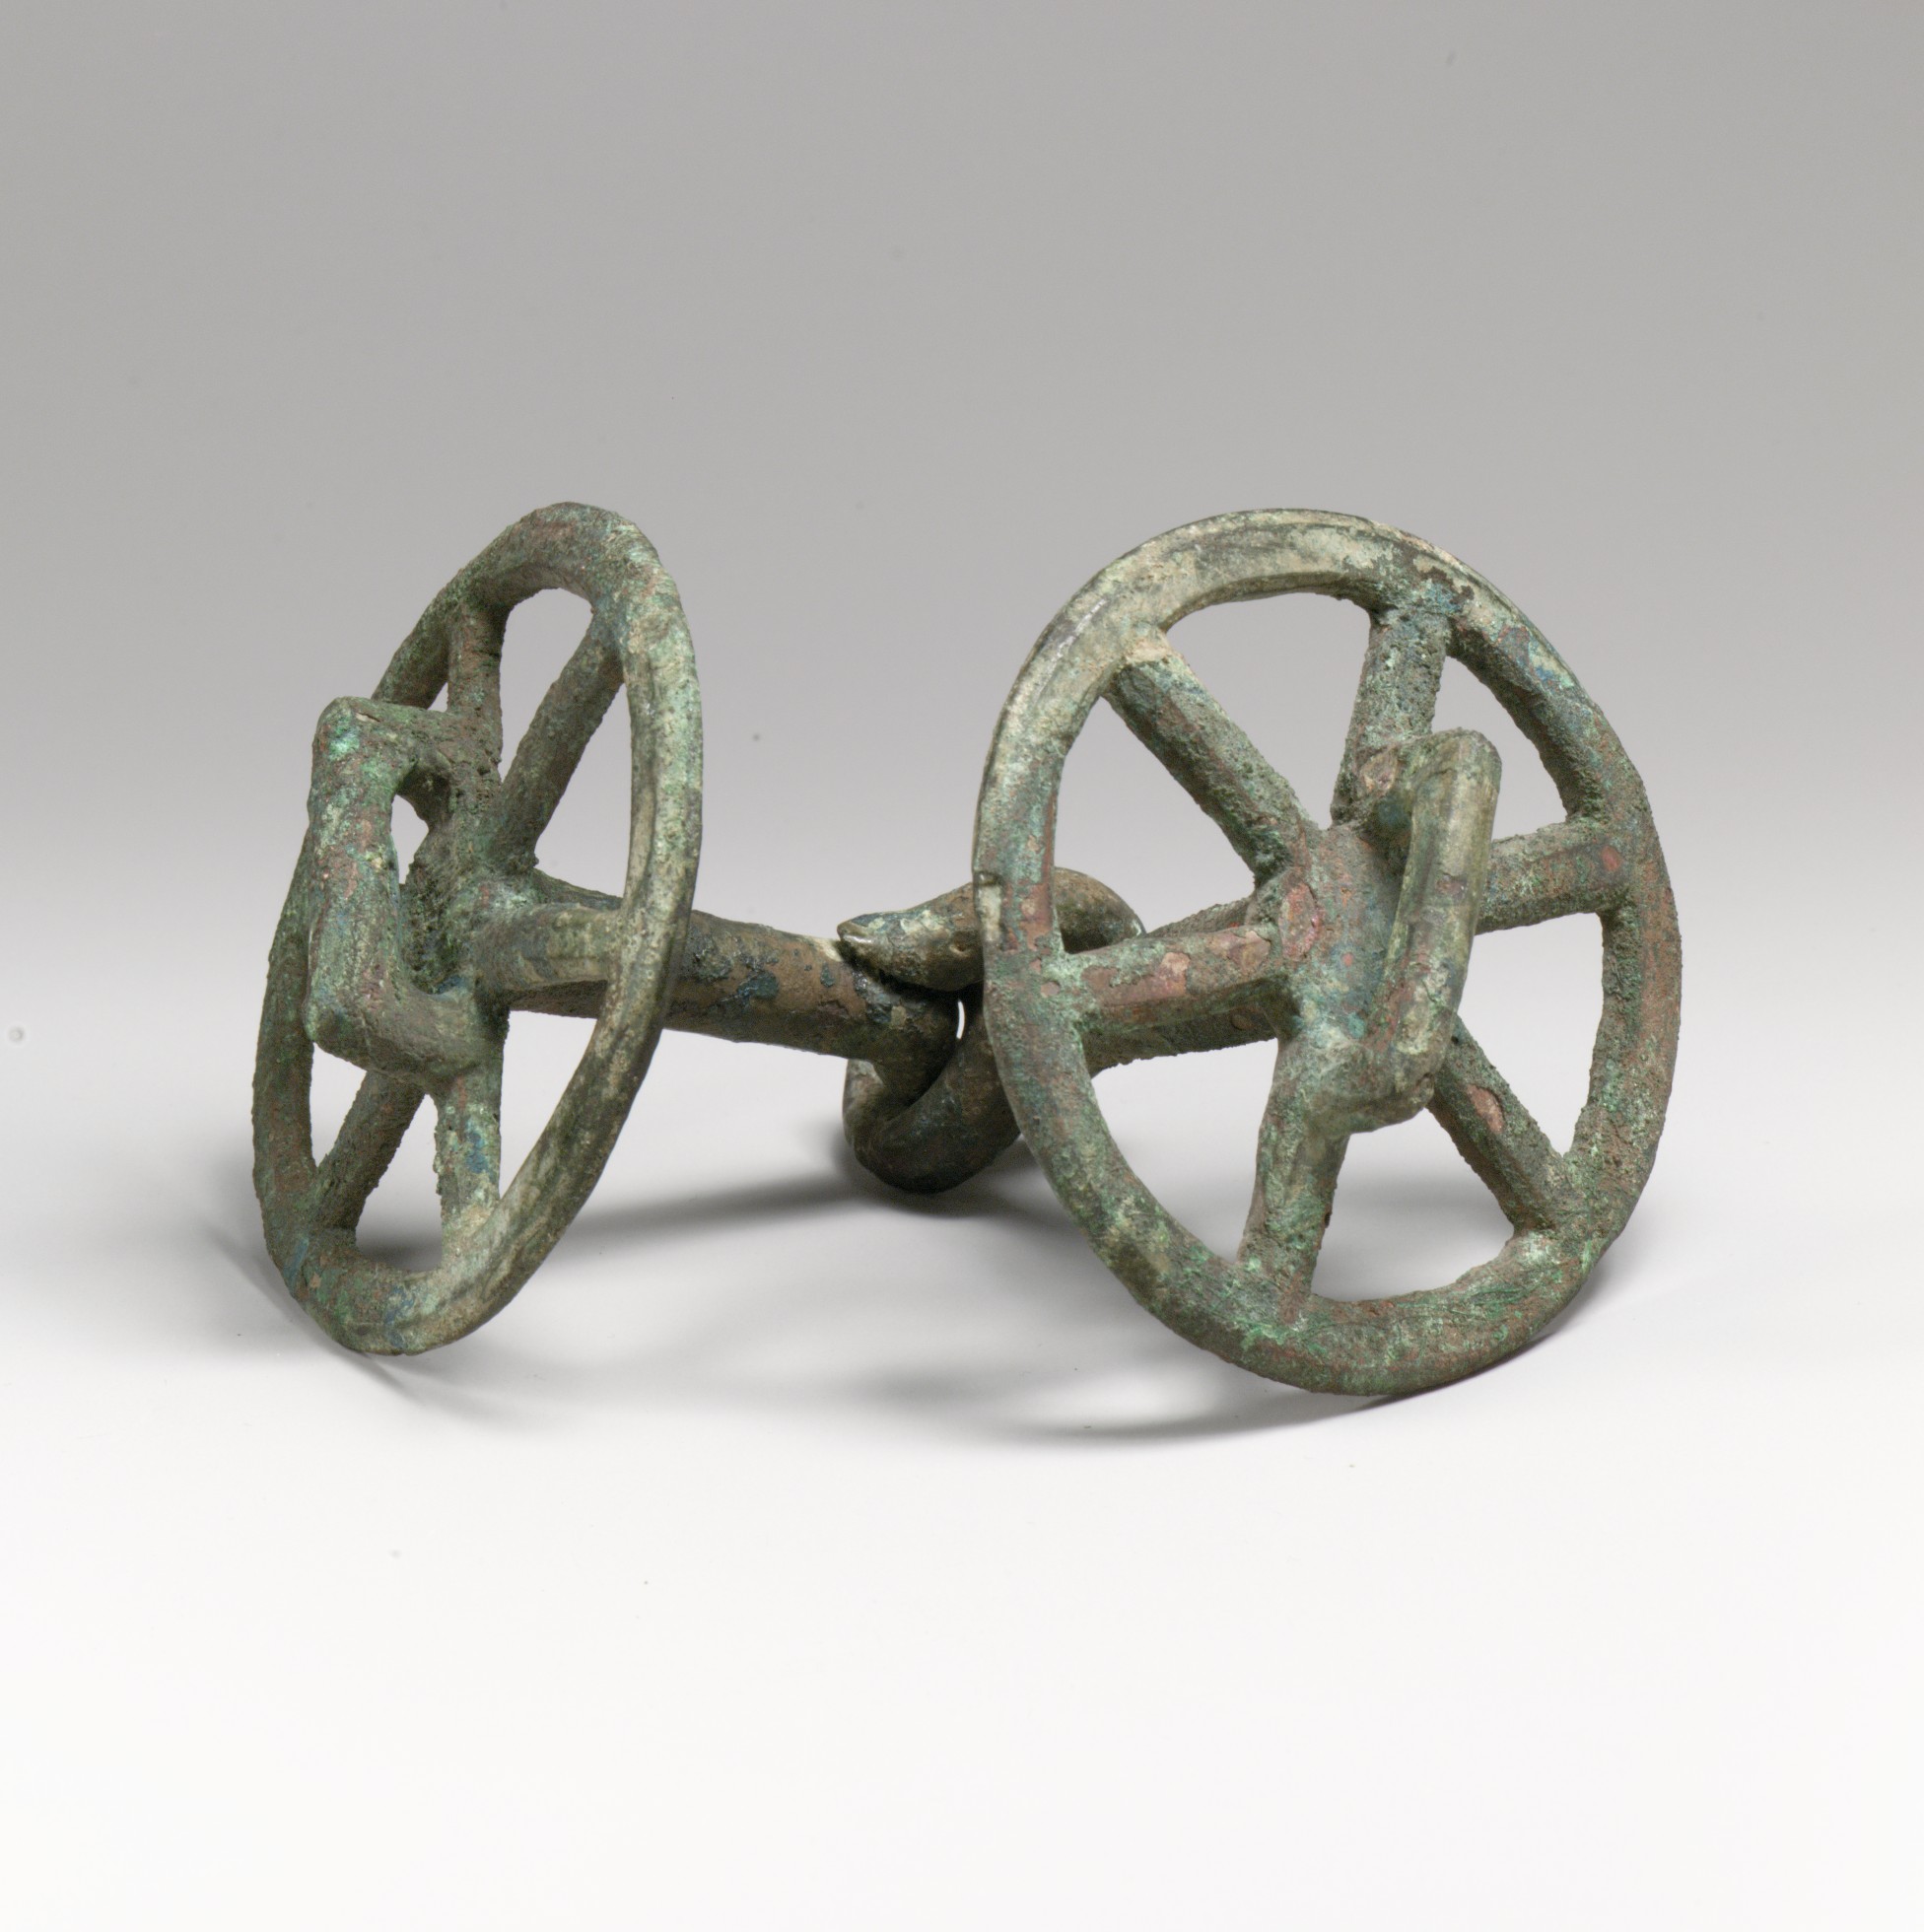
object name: horse bit, wheel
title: Bronze bit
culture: greek or near eastern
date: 1000-668 BCE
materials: bronze